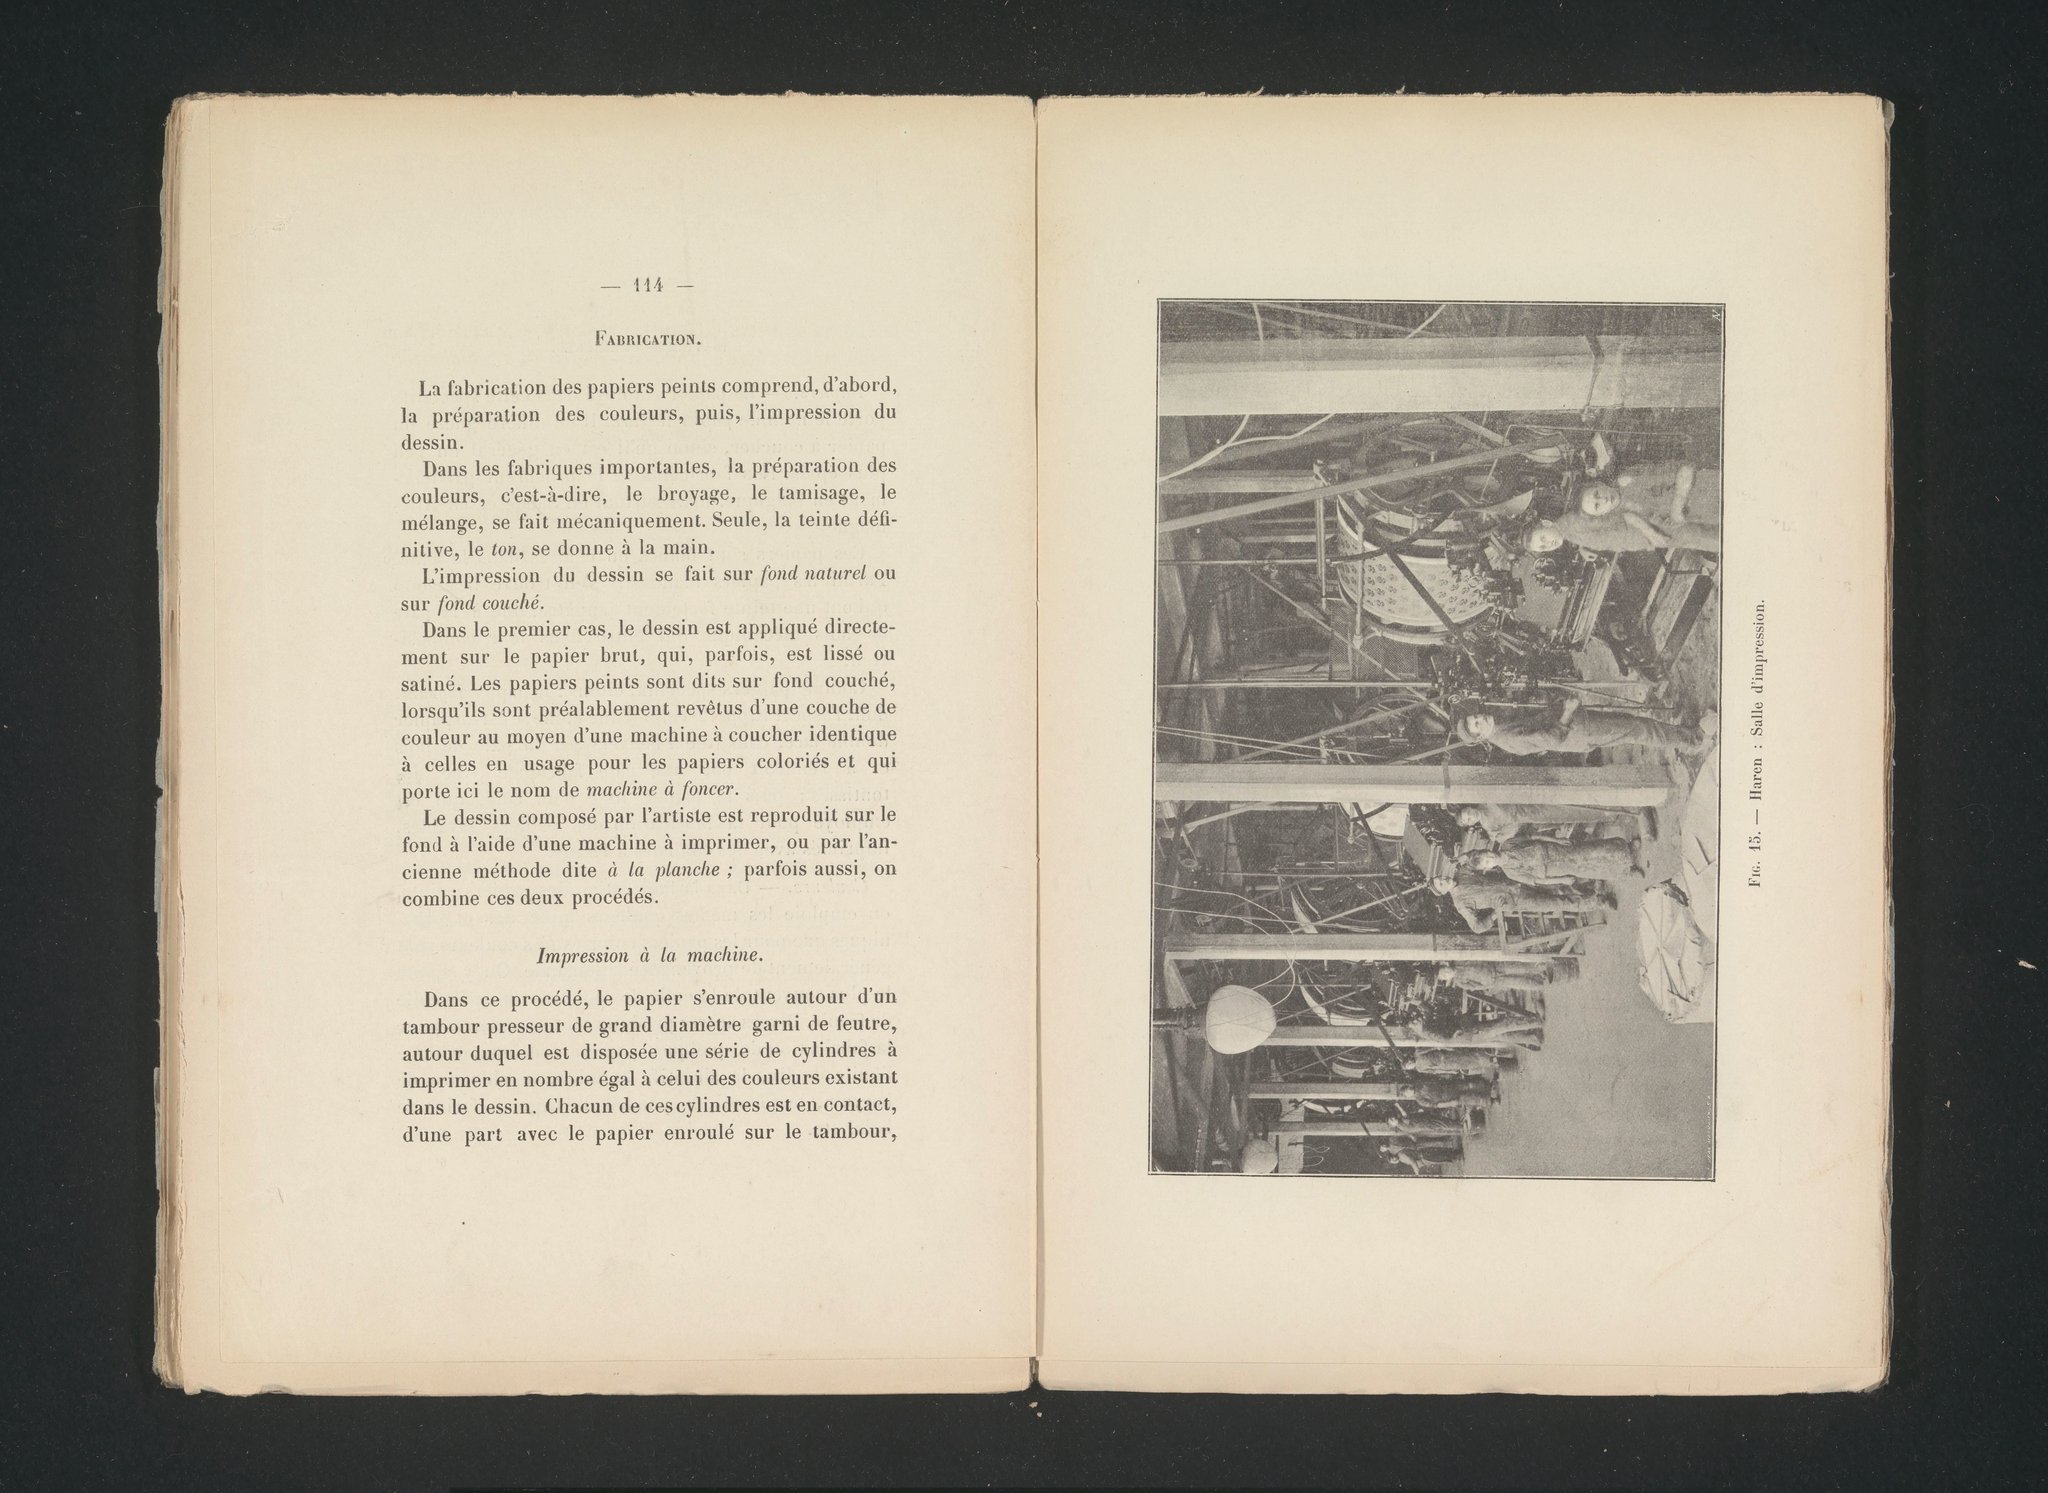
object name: photomechanical print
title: Gezicht op het interieur van een drukkerij in Haren, België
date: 1901-1906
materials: paper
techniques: autotype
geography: brussels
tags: printing, printing office, paper (writing material), workshop-interior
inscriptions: monogram: ‘AN’, inscription: ‘Fig. 15. - Haren: Salle d'impression.’